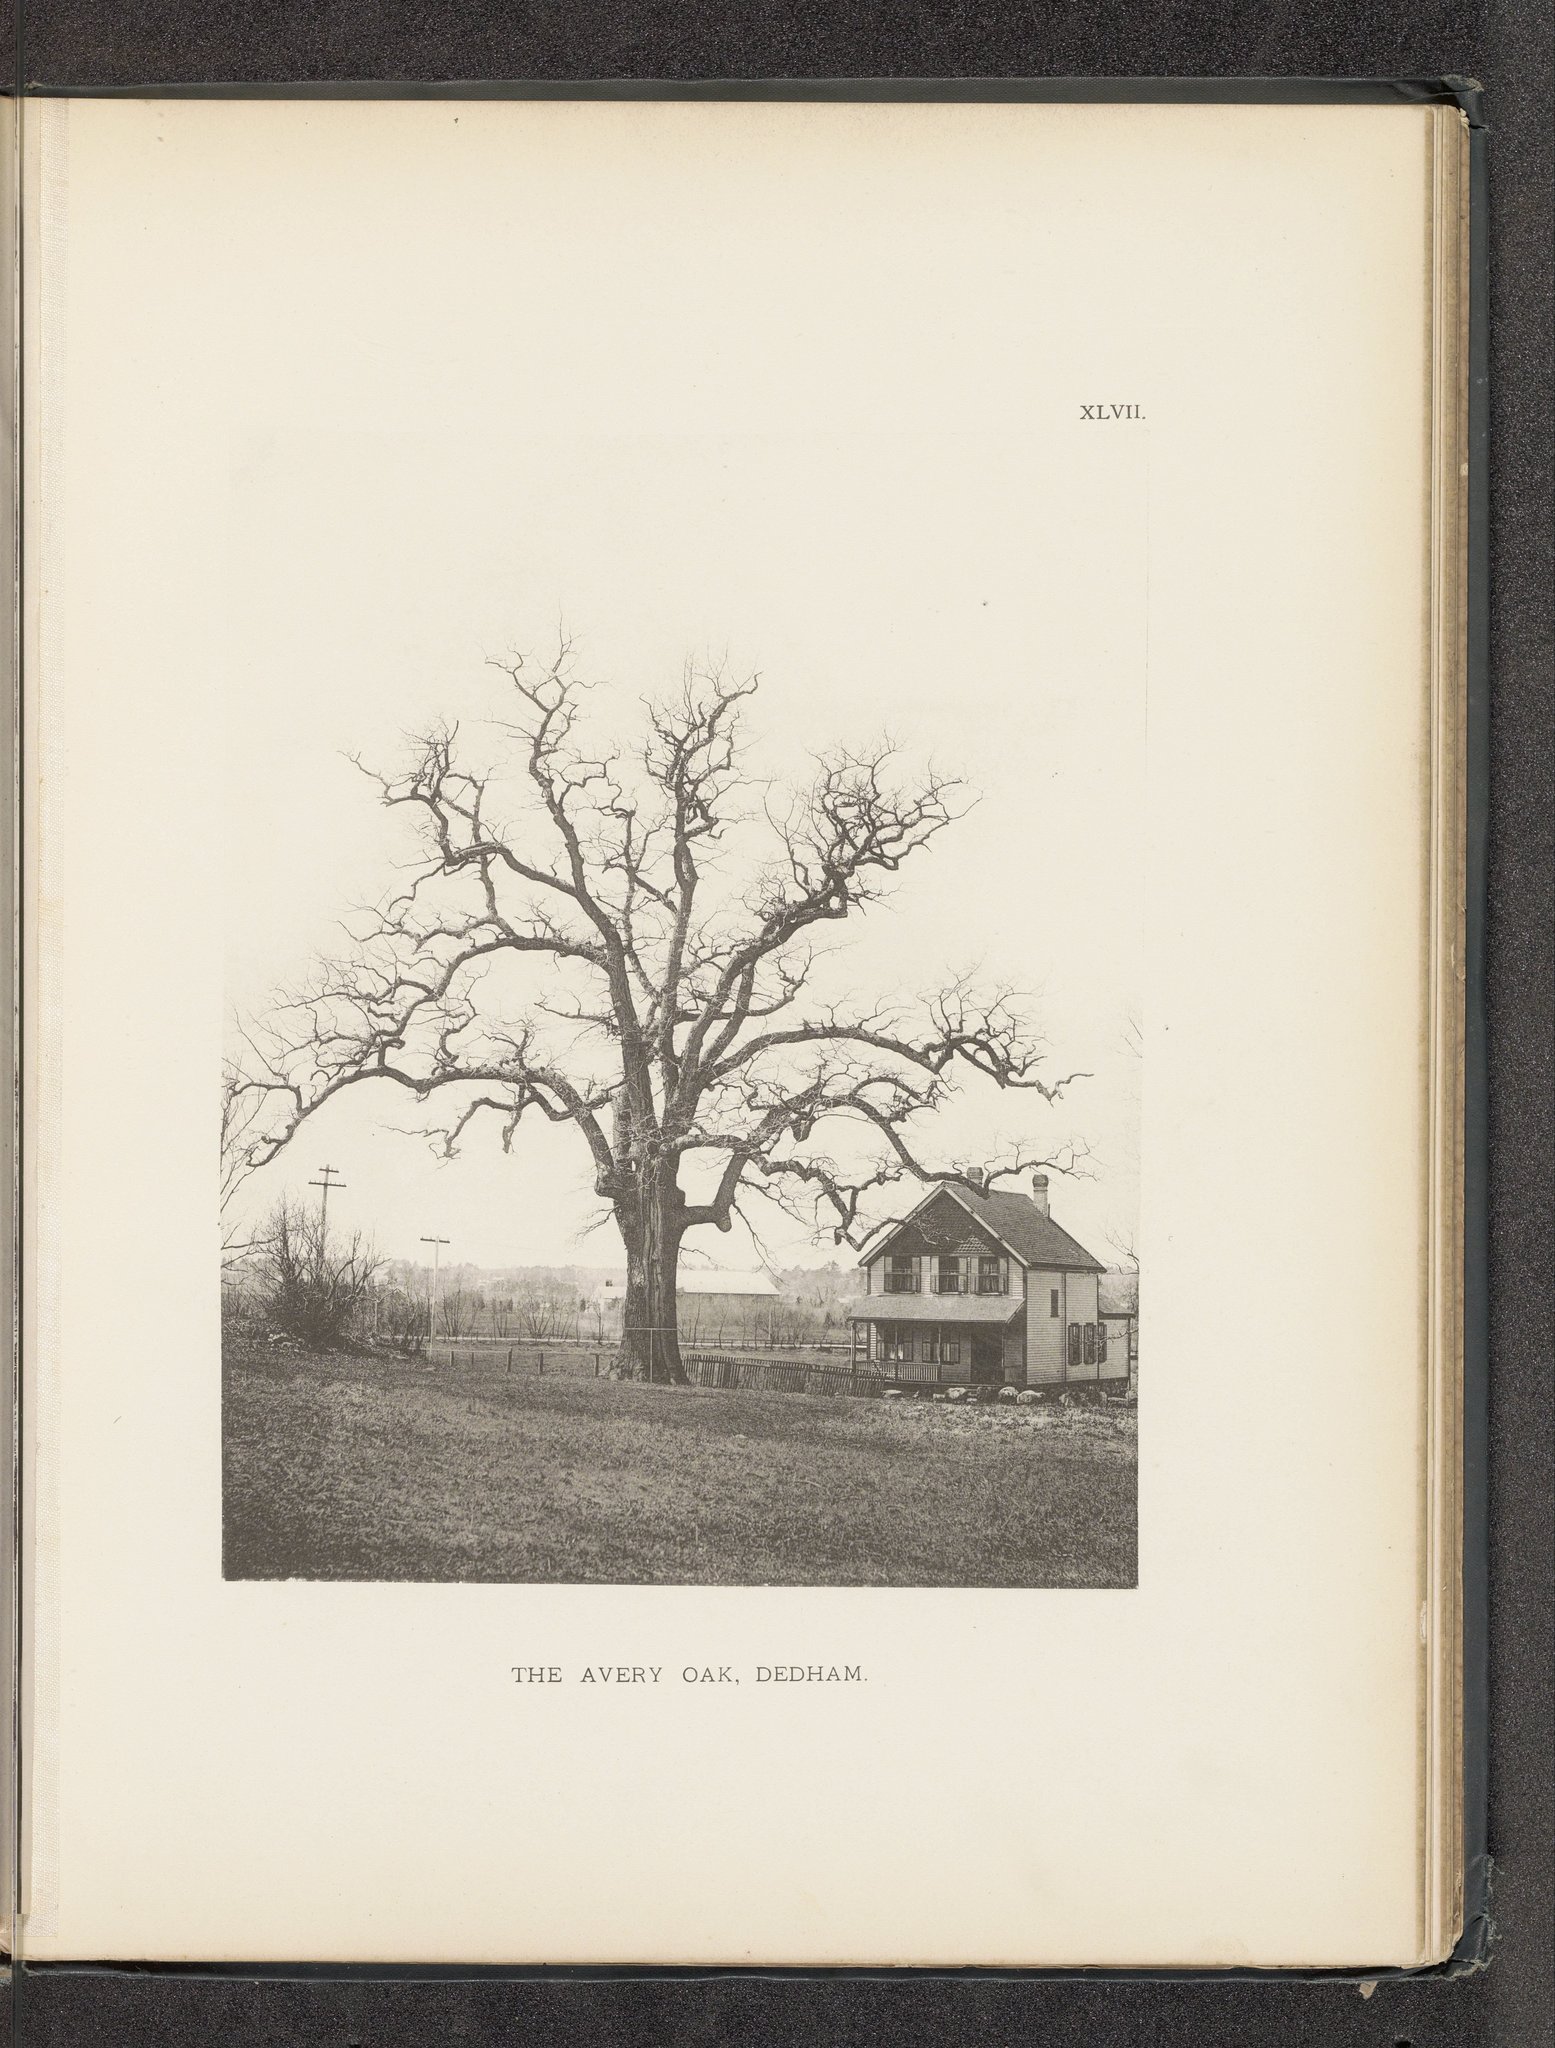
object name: photomechanical print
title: The Avery oak, Dedham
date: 1880-1890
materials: paper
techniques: photograph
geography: dedham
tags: trees: oak, public road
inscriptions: number: ‘XLVII.’